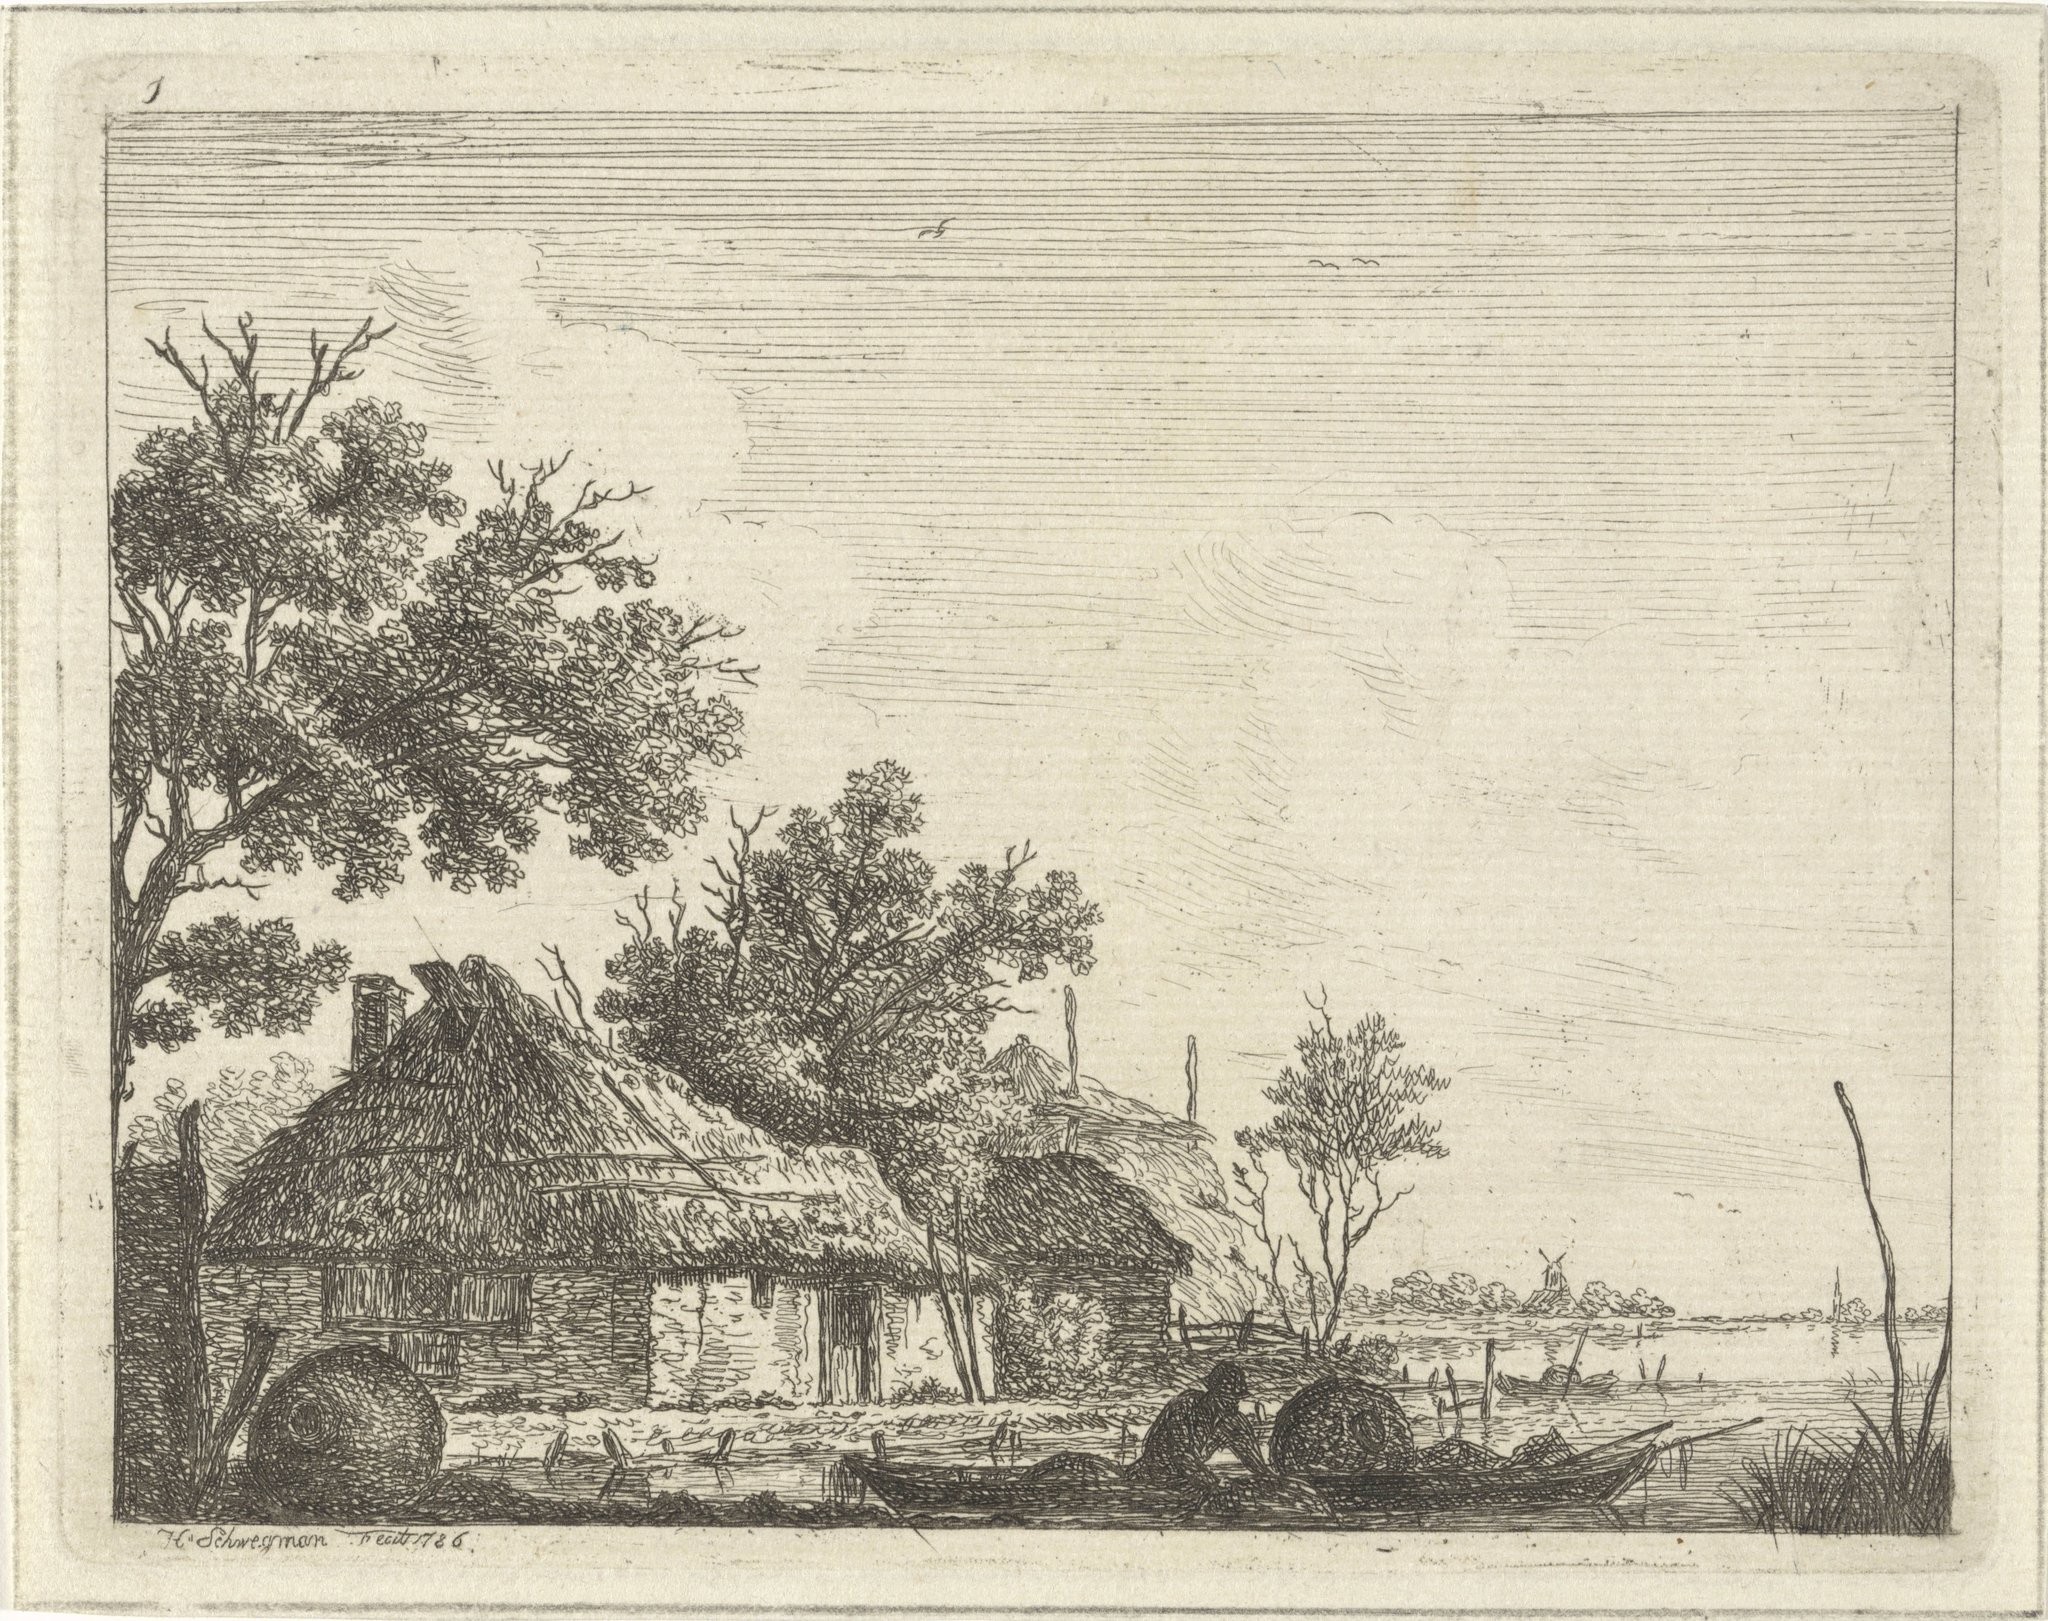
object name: print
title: Landschappen met woningen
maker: hendrik schwegman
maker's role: draughtsman, print maker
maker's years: 1761-1816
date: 1786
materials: paper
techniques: engraving, etching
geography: haarlem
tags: water course, farm or solitary house in landscape, fisherman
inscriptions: collector's mark: Lugt 2228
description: Landschap met een boerderij en hooiberg links. Op de voorgrond op het water een visser met fuiken in een boot.